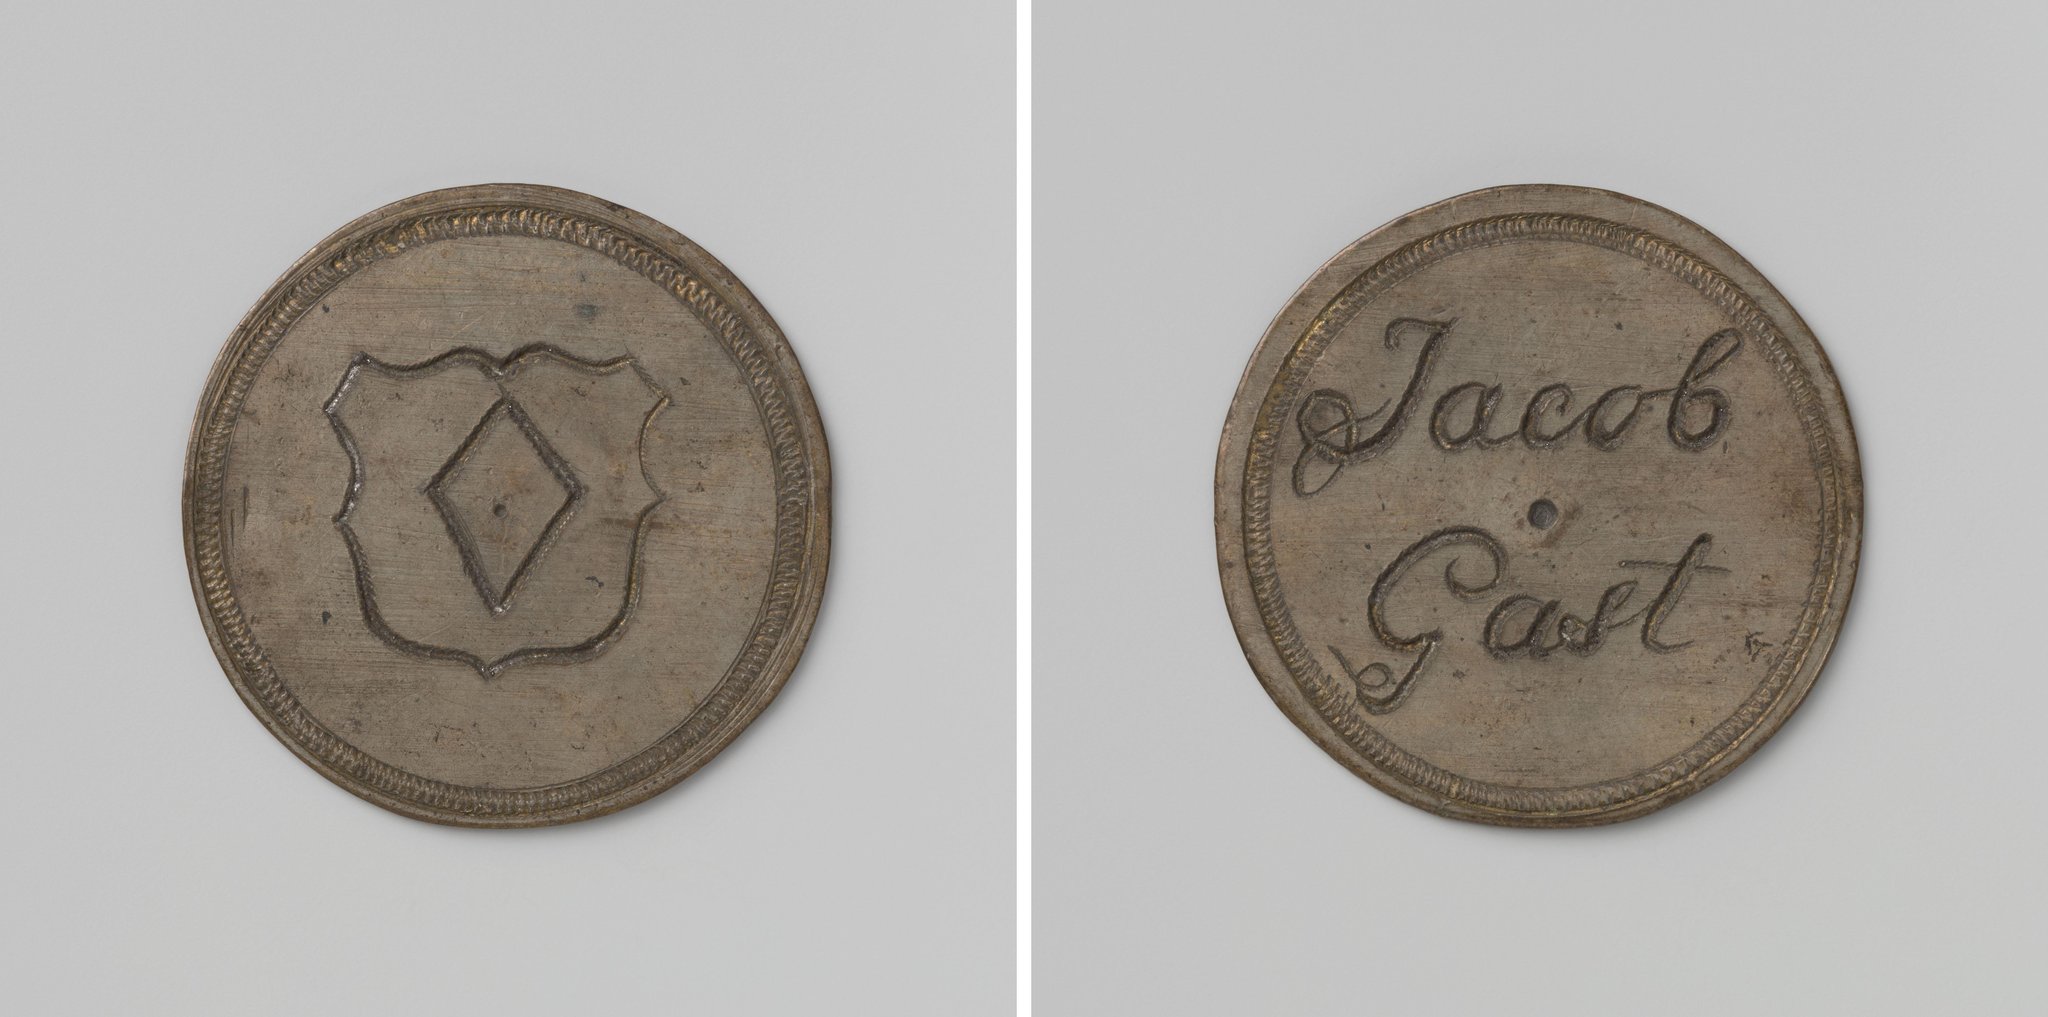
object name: medal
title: Schilders- en glazenmakersgilde van Enkhuizen, gildepenning van Jacob Gast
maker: Anonymous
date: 1636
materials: brass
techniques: engraving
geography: enkhuizen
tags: enkhuizen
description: Messing penning met gat in midden. Voorzijde: ruit in een hartvormig schild binnen kabelrand. Keerzijde: opschrift binnen kabelrand